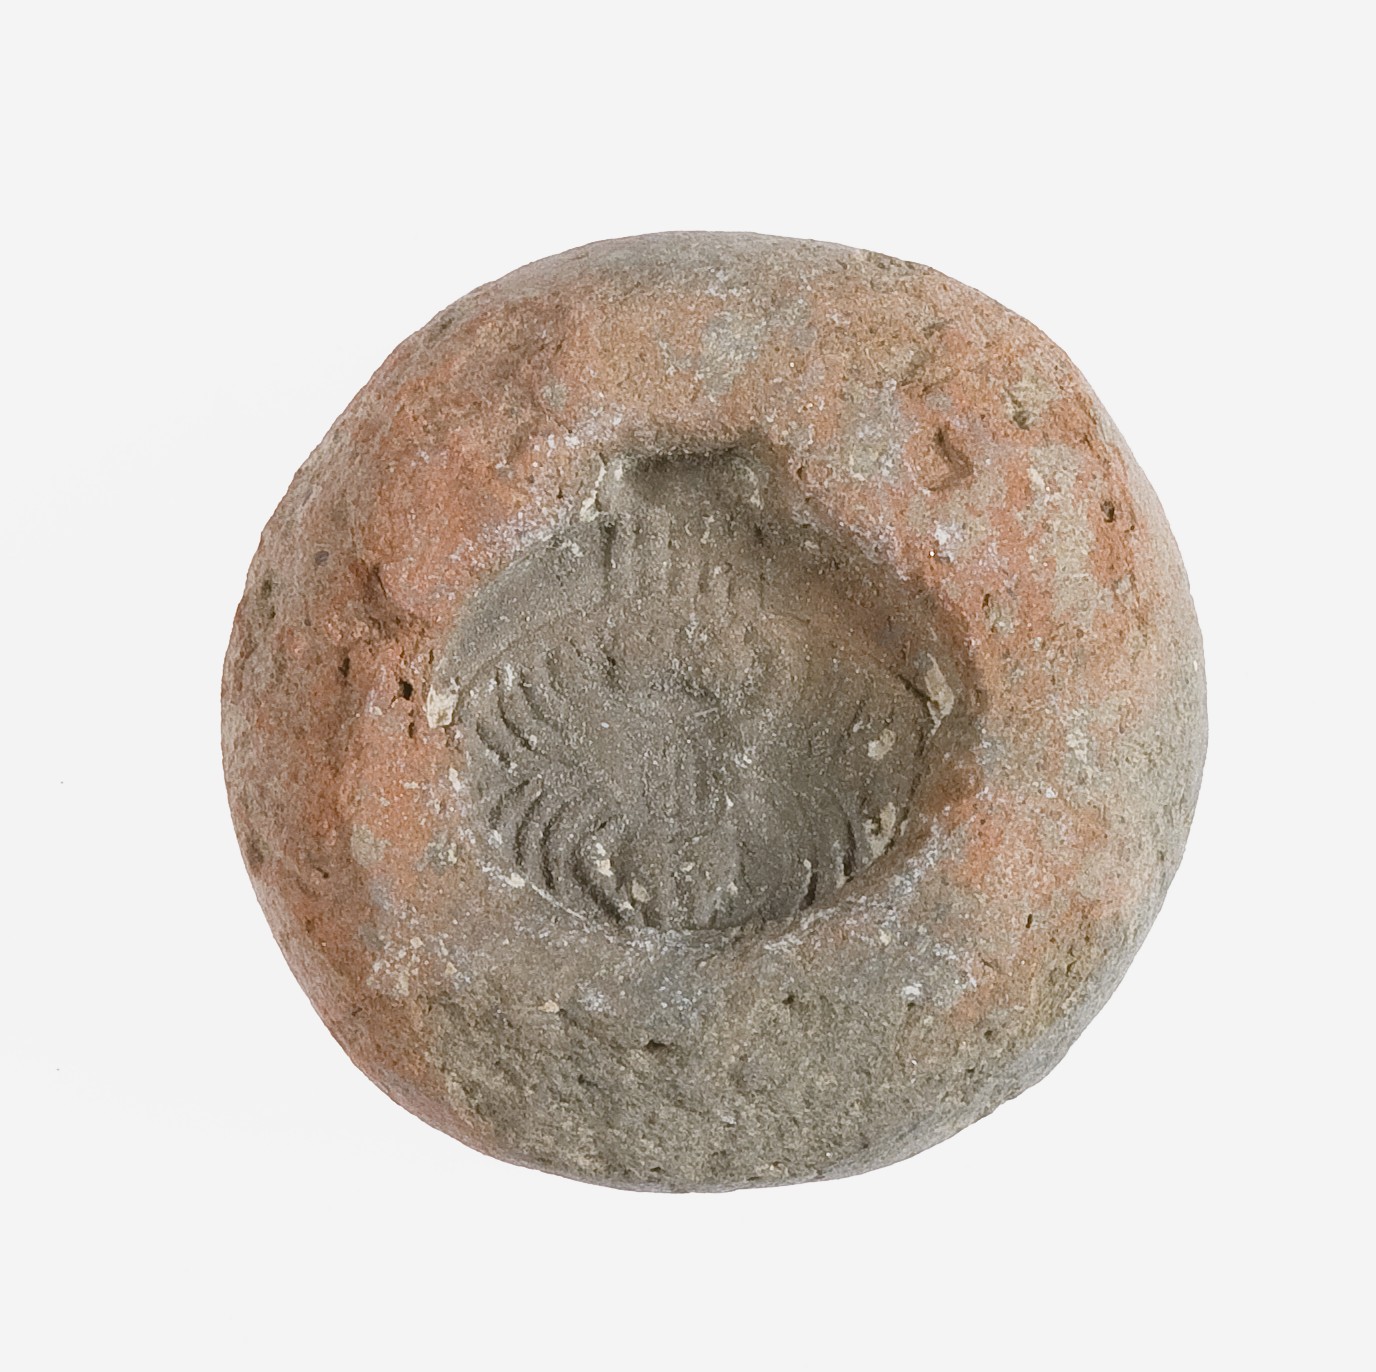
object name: mold, amulet, winged scarab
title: Mold for a Winged Scarab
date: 1390-1352 BCE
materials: pottery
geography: egypt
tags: scarabs